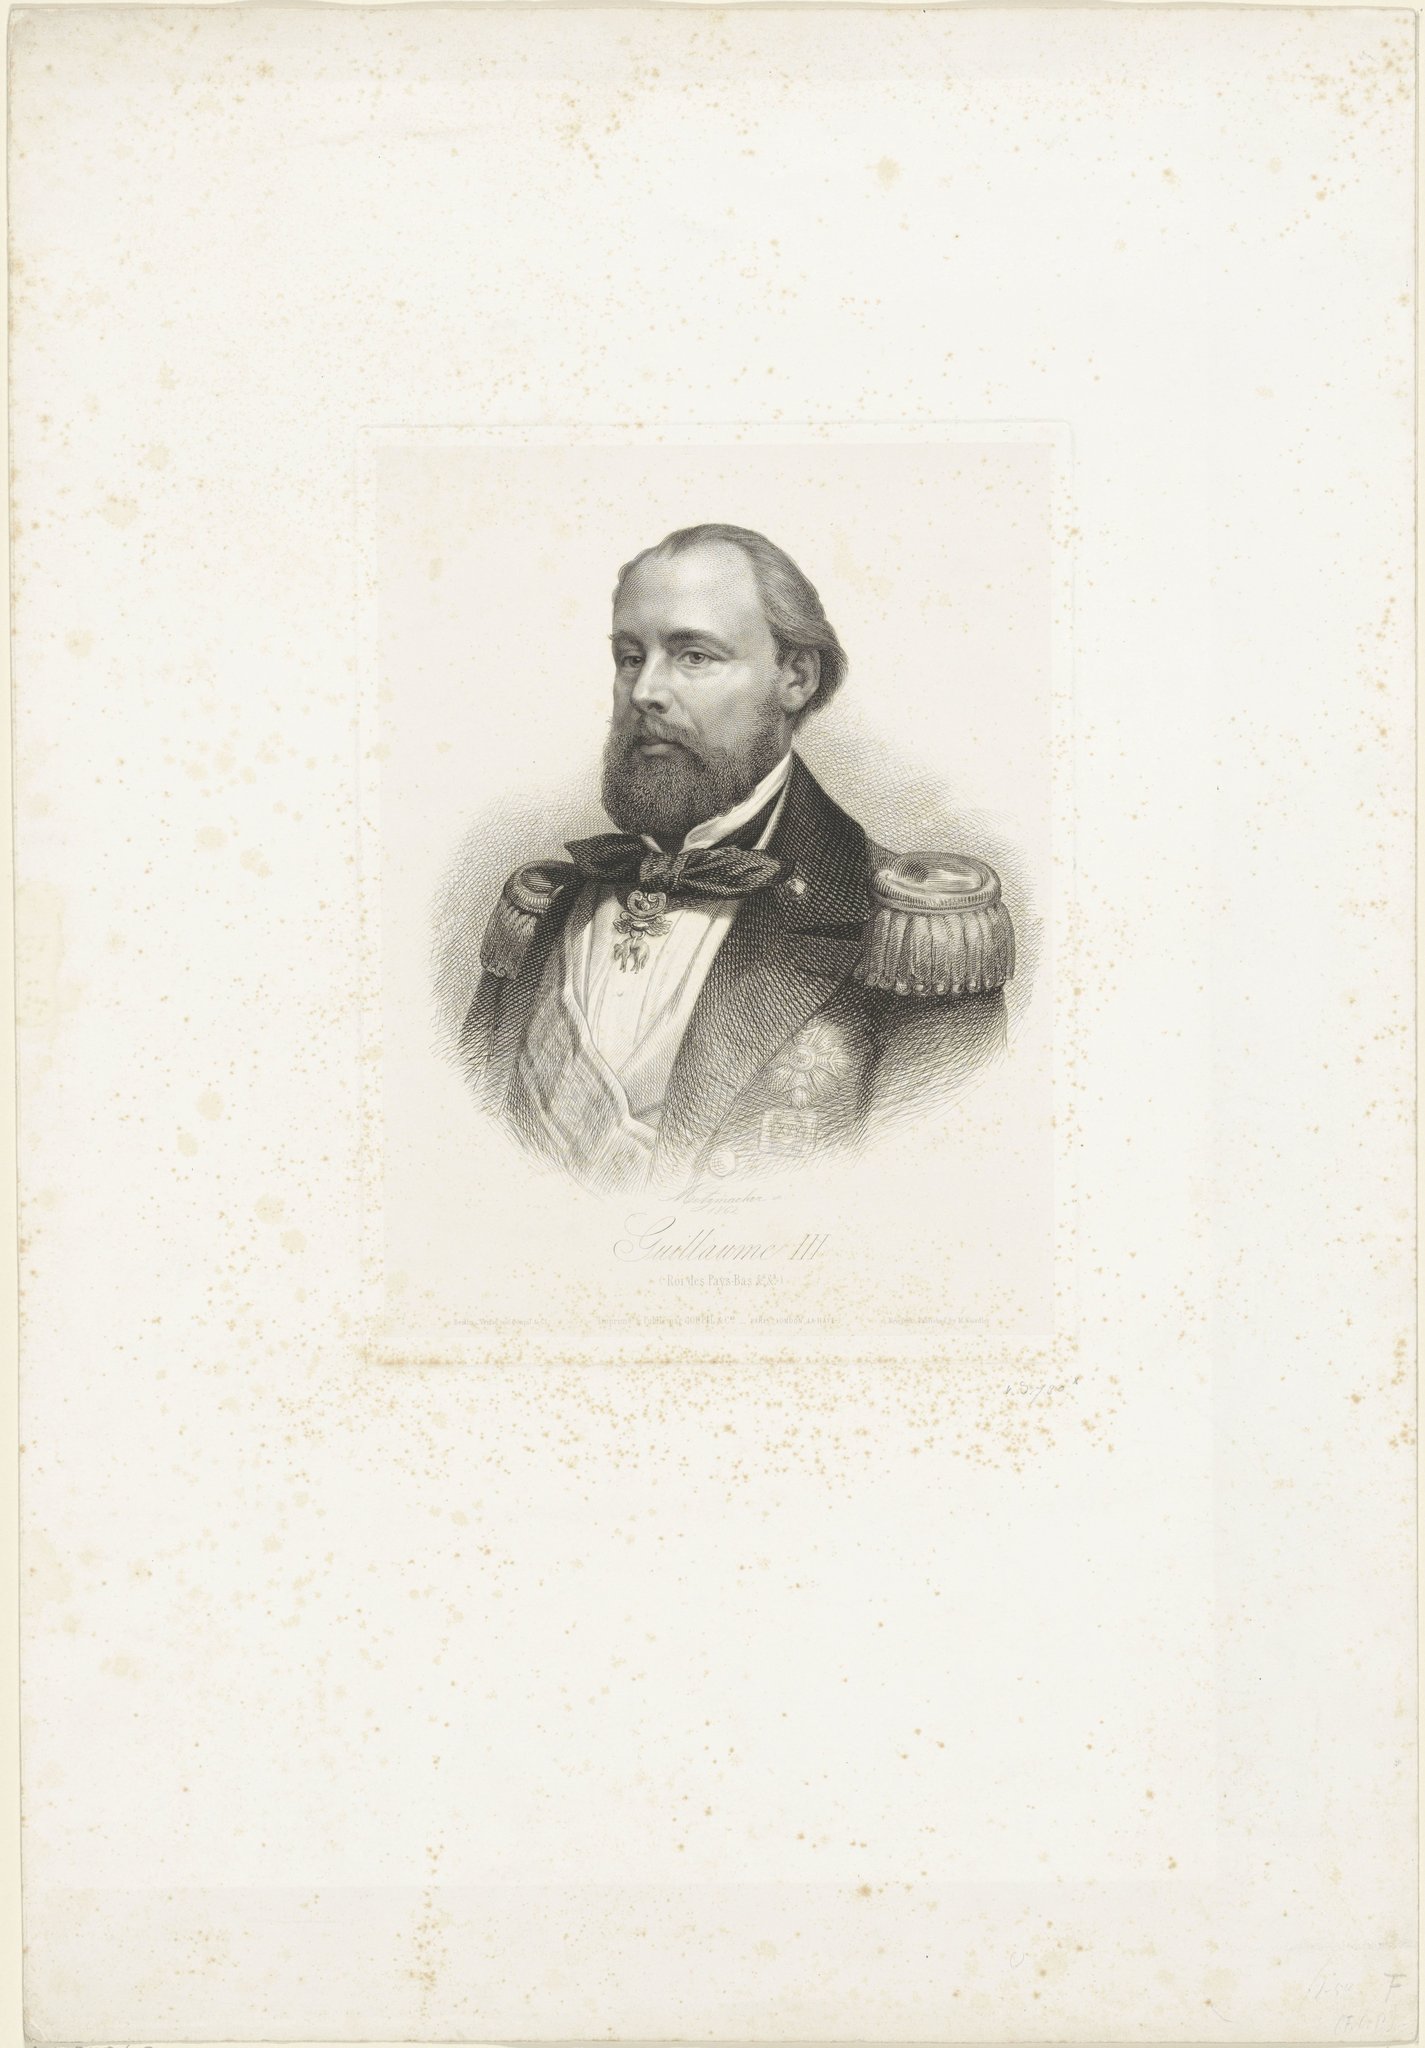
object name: print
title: Portret van Willem III, koning der Nederlanden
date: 1862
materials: paper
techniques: drypoint, engraving, etching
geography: london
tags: brussels, willem iii (koning der nederlanden), knighthood order of the golden fleece - insignia of a knighthood order, e.g.: badge, chain (with name of order)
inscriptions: collector's mark: Lugt 2165, collector's mark: Lugt 963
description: De hier vermelde titel verwijst naar de hoogst verkregen titel van de geportretteerde, niet per se naar de titel die de geportretteerde op deze voorstelling draagt.